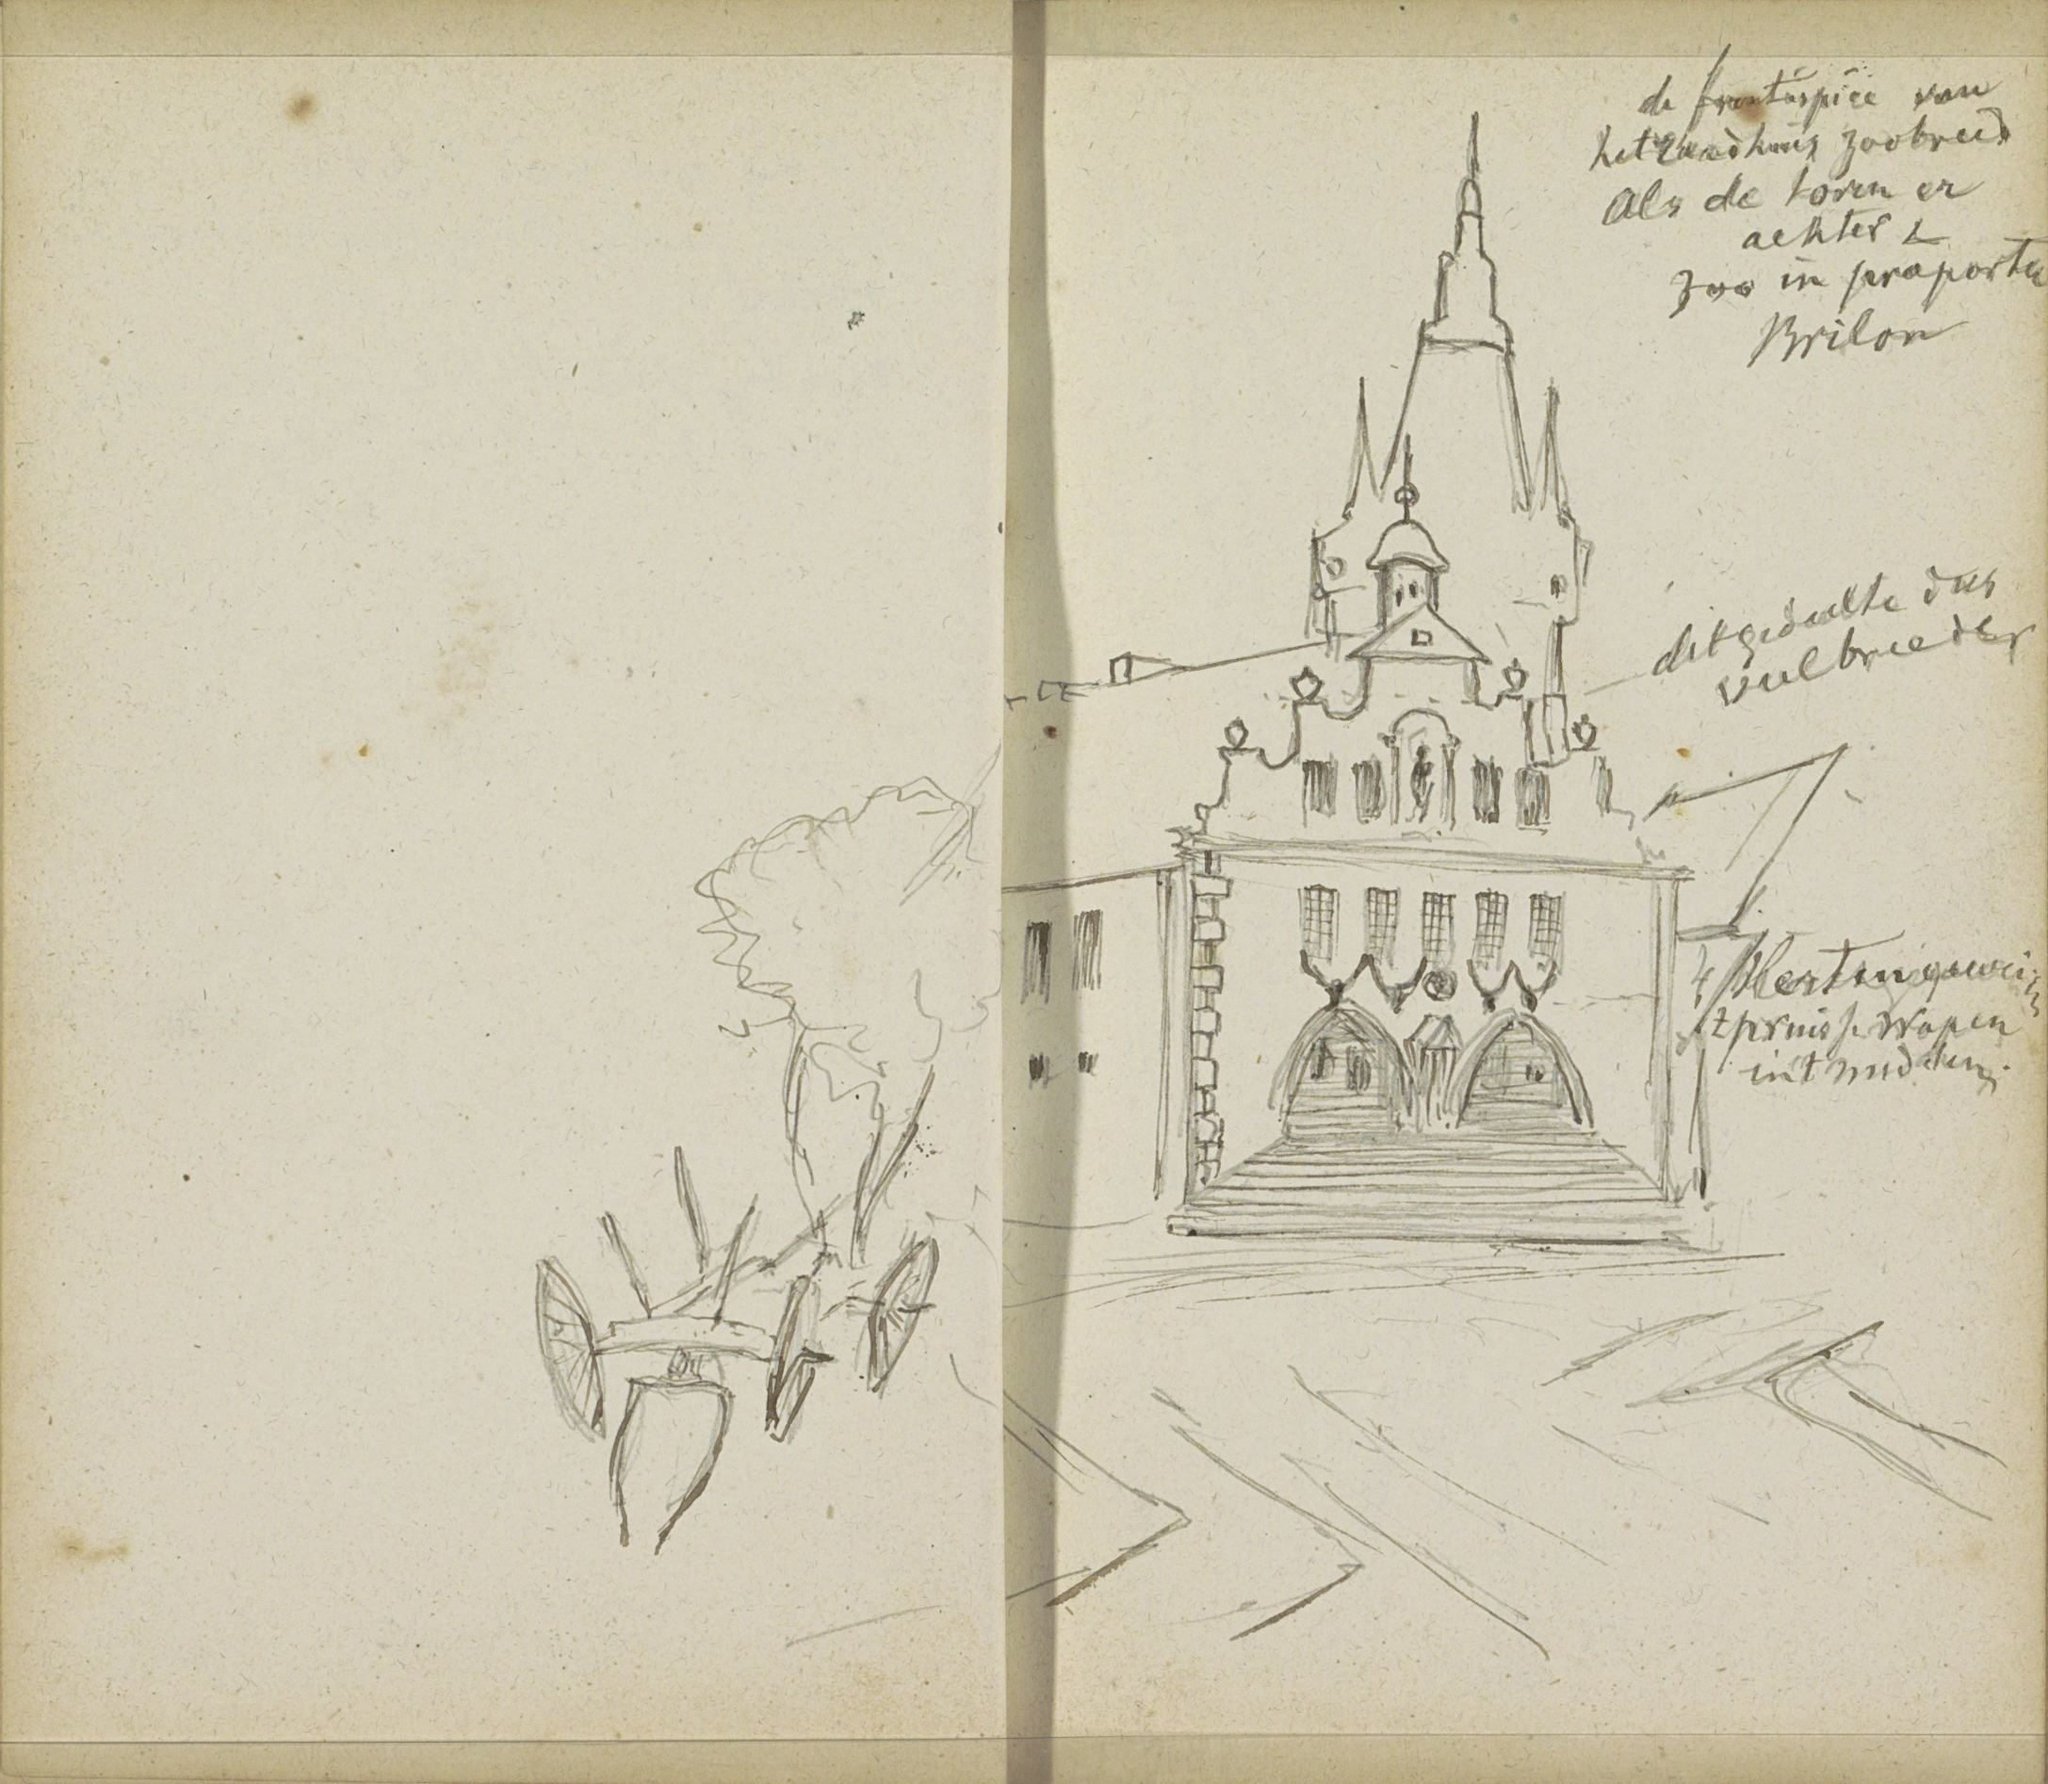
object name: sketchbook leaf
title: St. Petrus und Andreaskirche te Brilon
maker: johannes tavenraat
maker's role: draughtsman, painter, print maker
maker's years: 1809-1881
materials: ink, paper, pencil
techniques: pen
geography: brilon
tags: church (exterior)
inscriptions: annotation: ‘de frontispice van/ het [...] zpp breed/ als de toren er/ achter/ zoo in proportie/ Brilon/ dit gedeelte [...]/ veel breder/ [...]’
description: Blad 23 verso en 24 recto uit een schetsboek met 88 bladen.